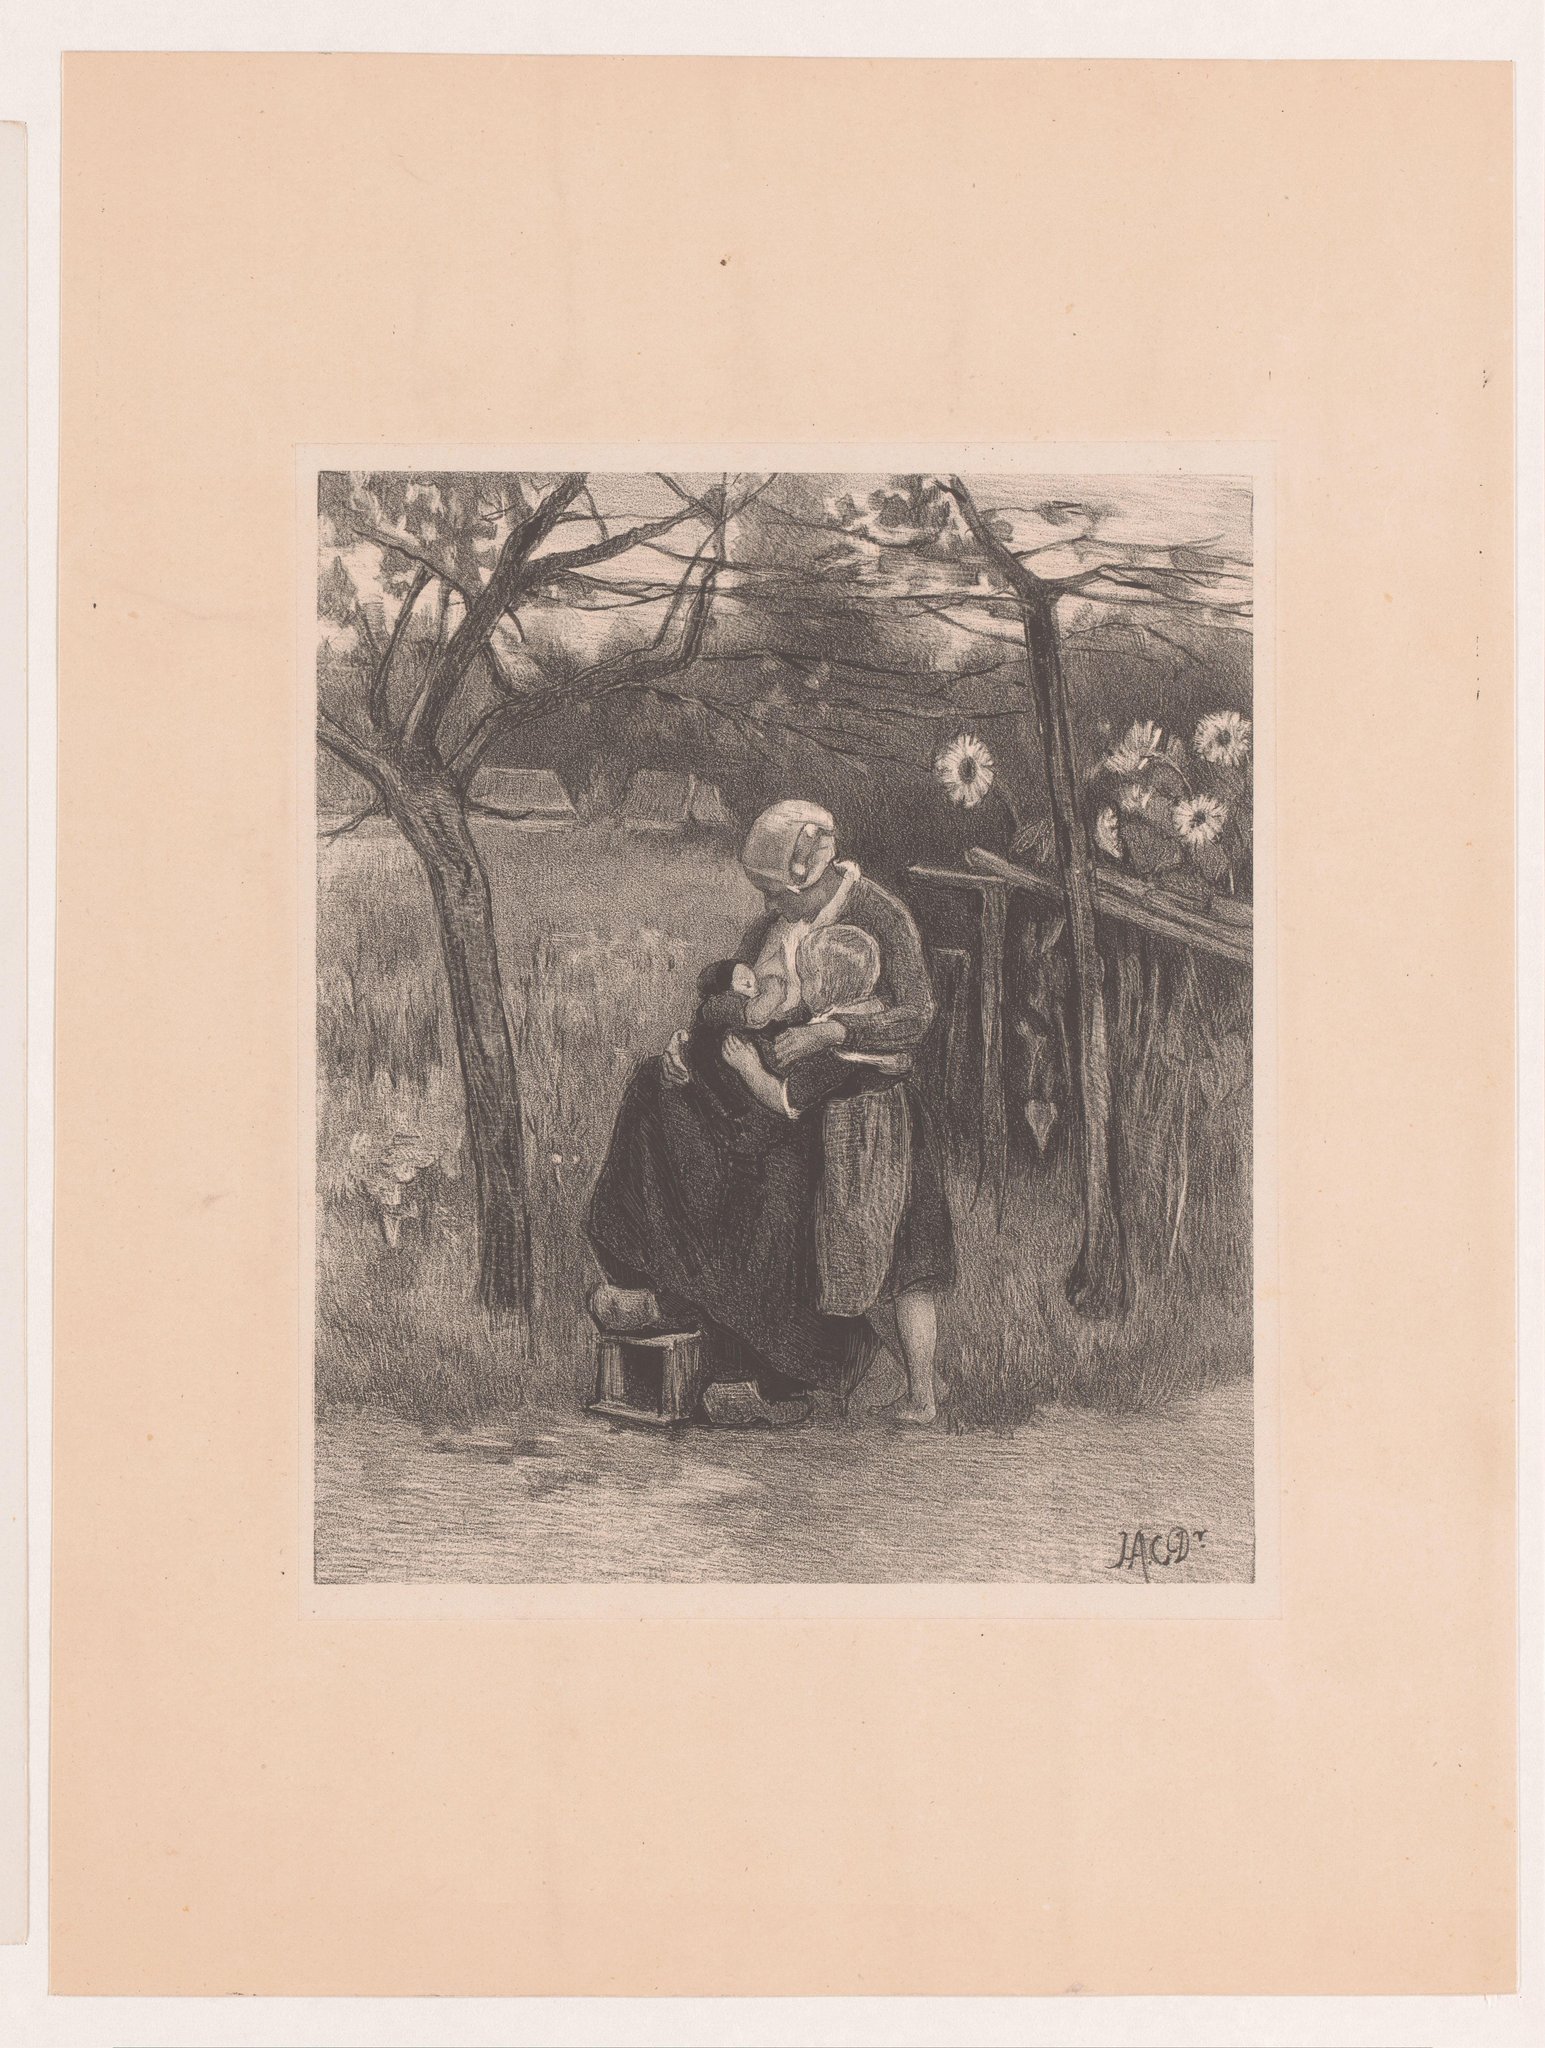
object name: print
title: Boerin in landschap met twee kinderen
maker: hendrik adriaan christiaan dekker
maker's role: draughtsman, print maker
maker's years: 1836-1905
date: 1846-1905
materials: paper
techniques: lithograph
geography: amsterdam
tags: flowers, breasts giving milk, farmers - aa - female farmer, farmer's wife, mother and child(ren), woman and child(ren) (family group)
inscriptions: collector's mark: Lugt 2228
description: De boerin heeft een baby aan de borst terwijl het andere kind tegen haar aan staat. Achter hen staan zonnebloemen, bomen en twee huizen.